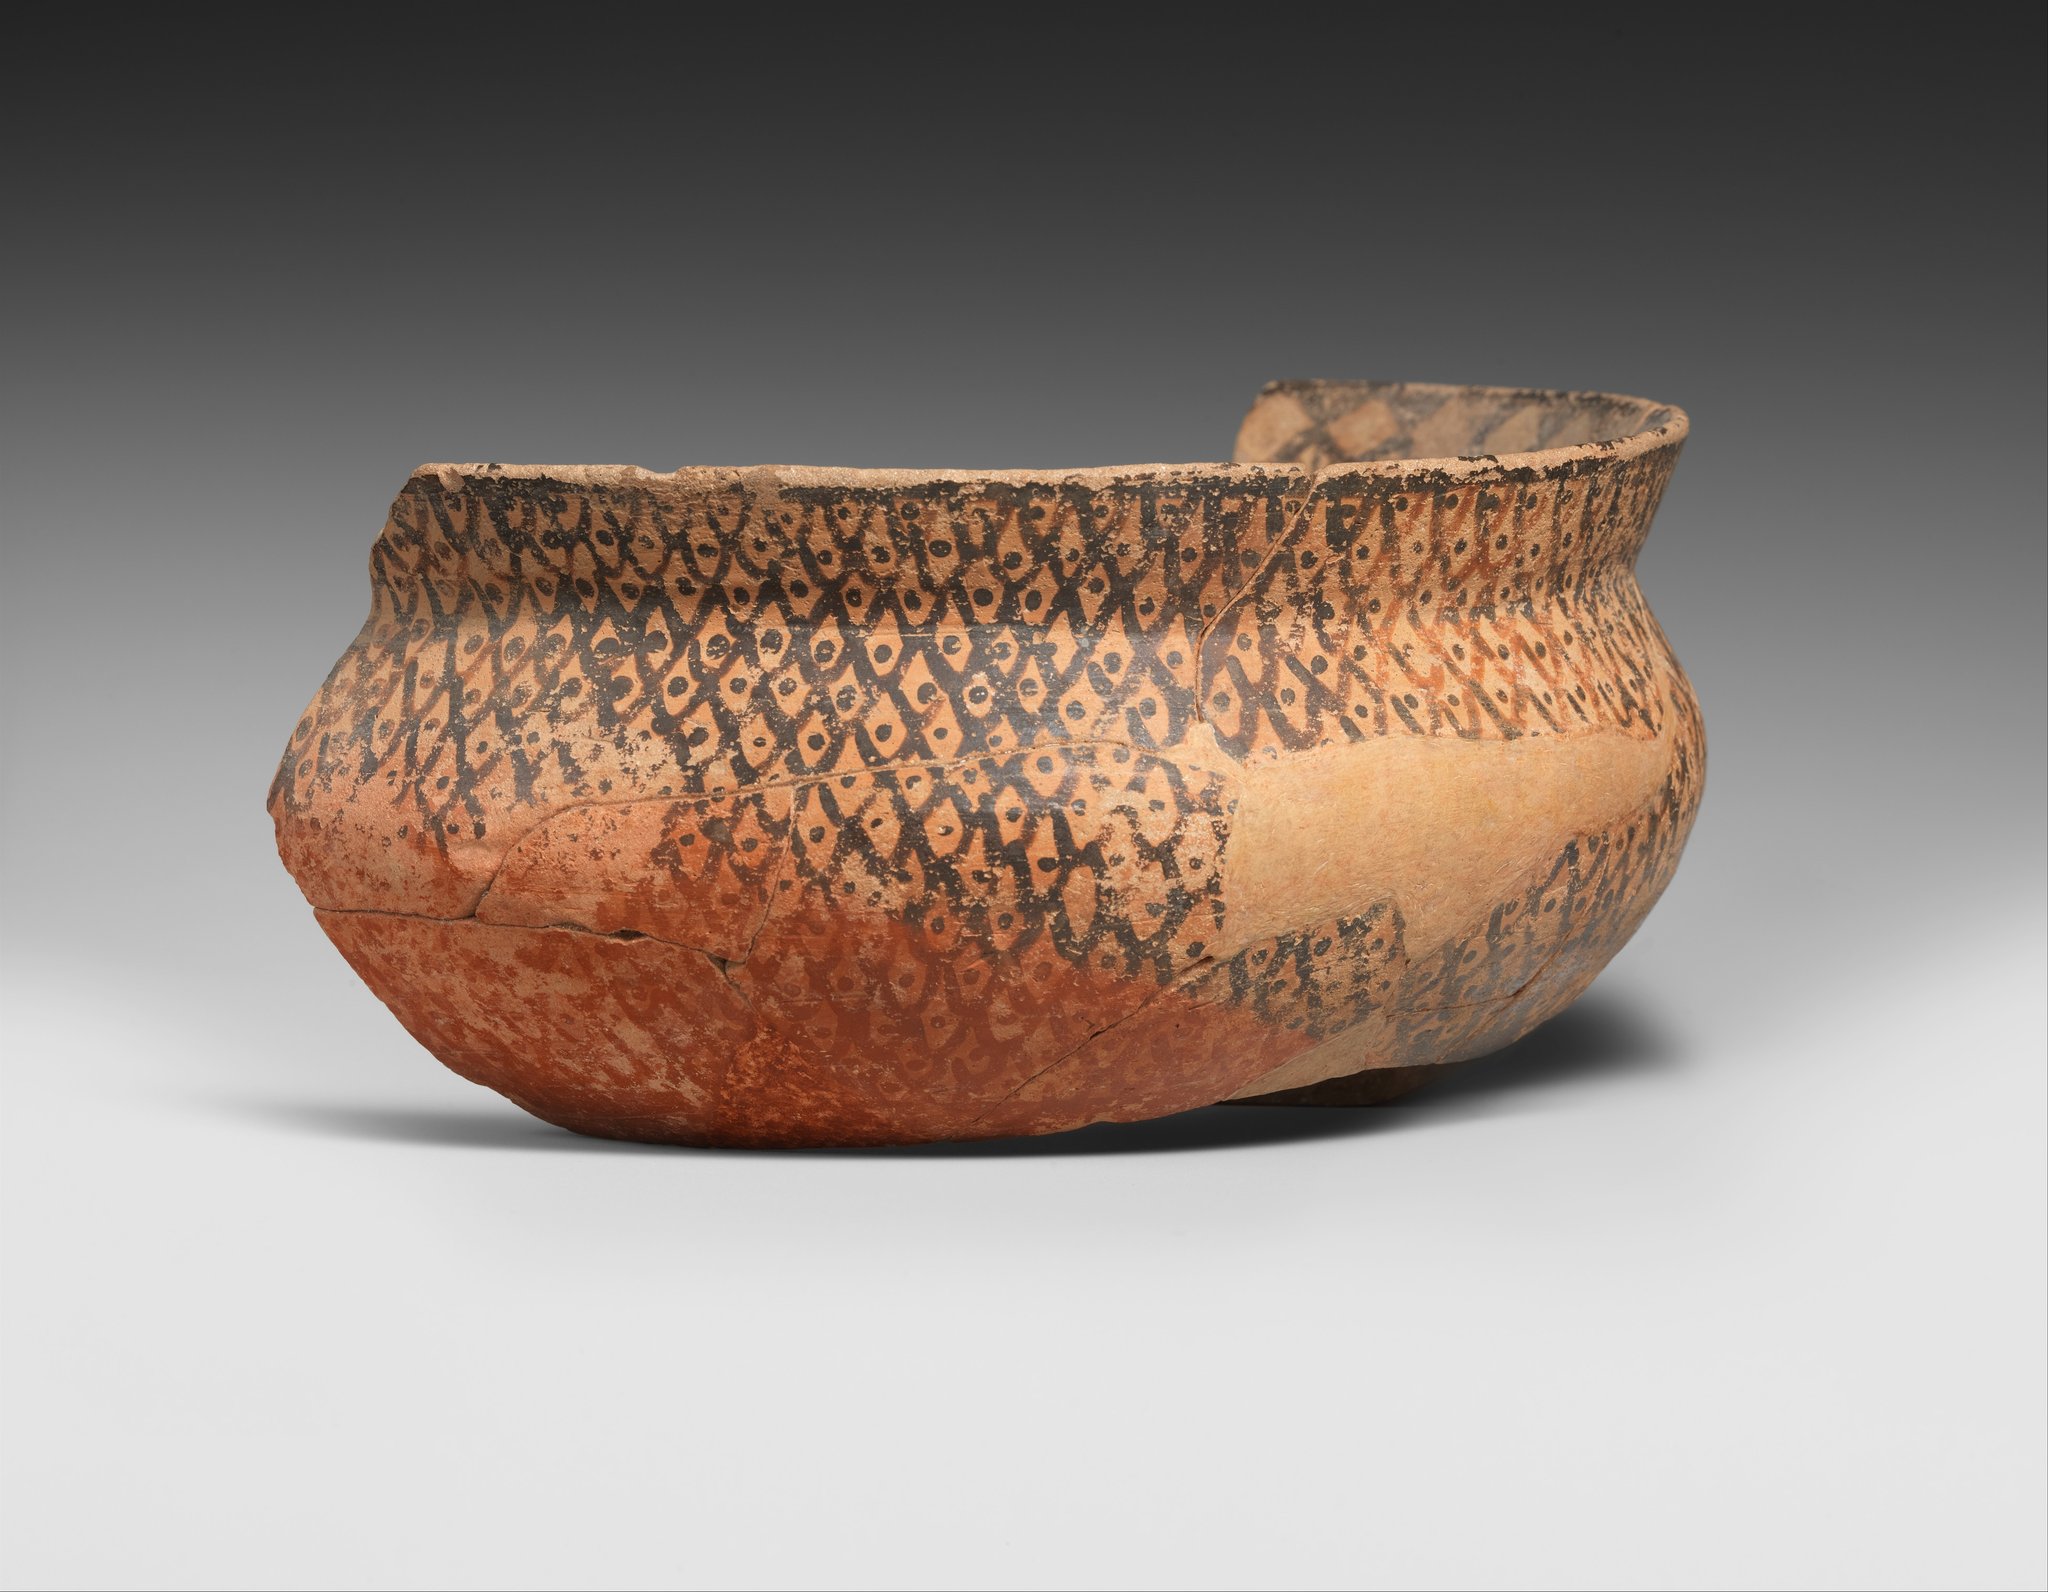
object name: bowl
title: Bowl fragment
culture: halaf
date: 5600-5000 BCE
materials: ceramic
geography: syria